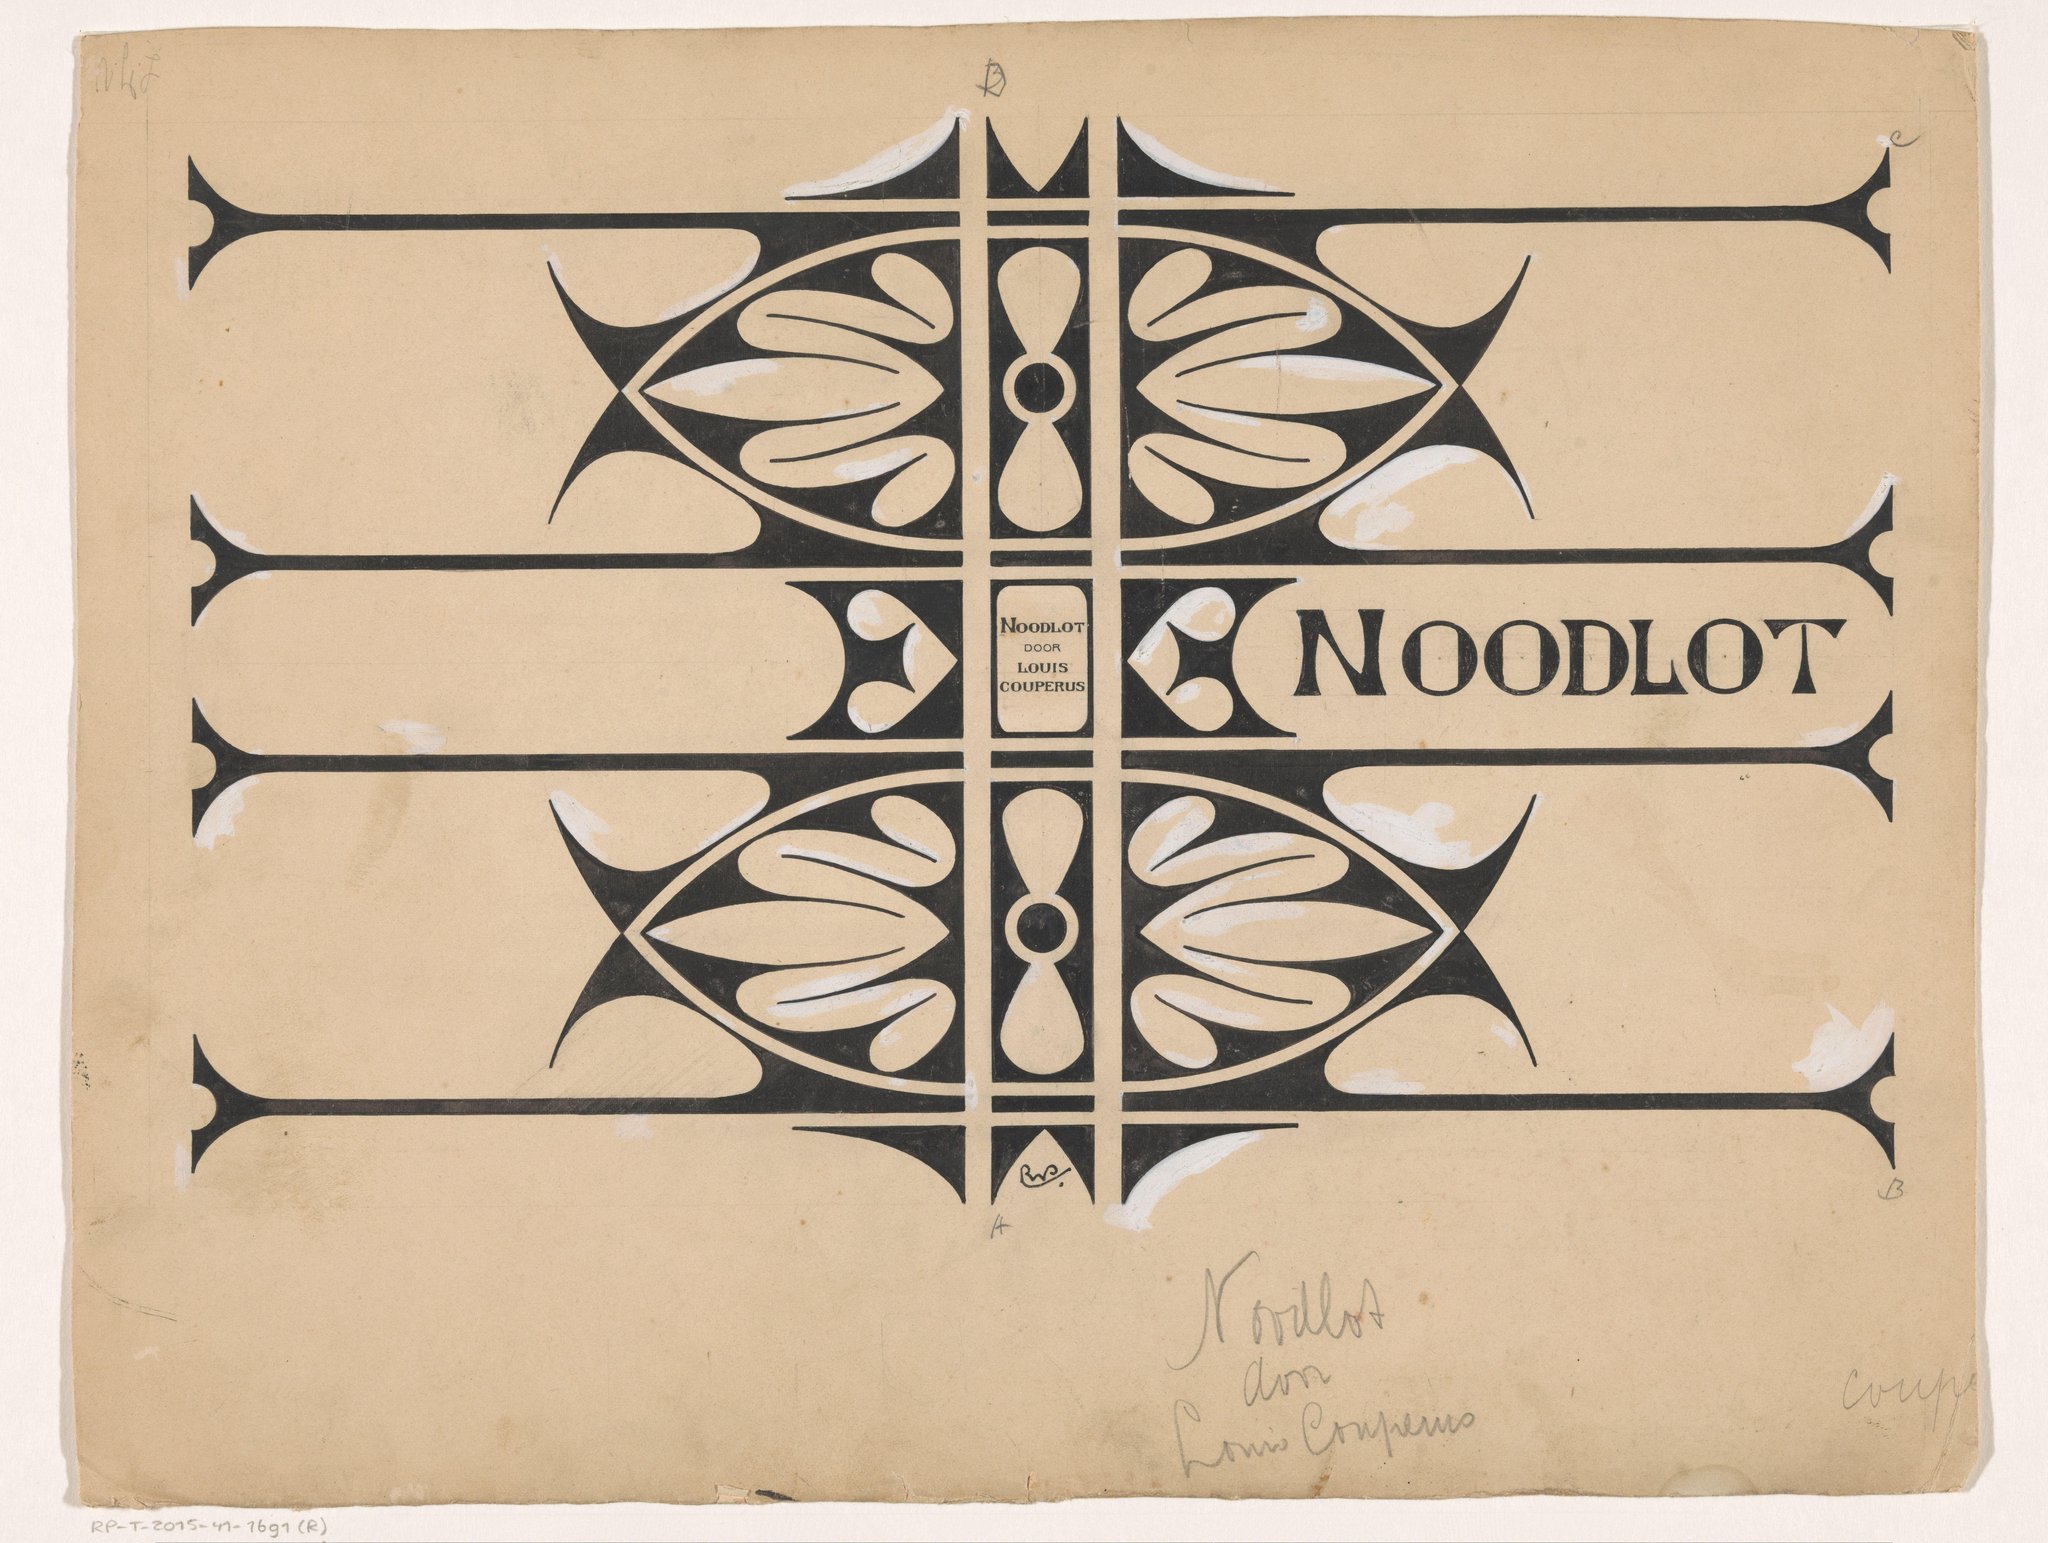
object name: study for binding design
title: Bandontwerp voor: Louis Couperus, Noodlot, 1898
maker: reinier willem petrus de vries (1874-1953)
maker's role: draughtsman, print maker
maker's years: 1874-1953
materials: cardboard, paint, ink, pencil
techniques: brush, pen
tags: ornaments ~ art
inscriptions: monogram: ‘RWPV’, annotation: ‘A/ B/ Noodlot/ door/ Louis Couperus/ coup’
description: Ontwerp met symmetrische lijnen en vormen doorlopend over het voor- en achterplat.